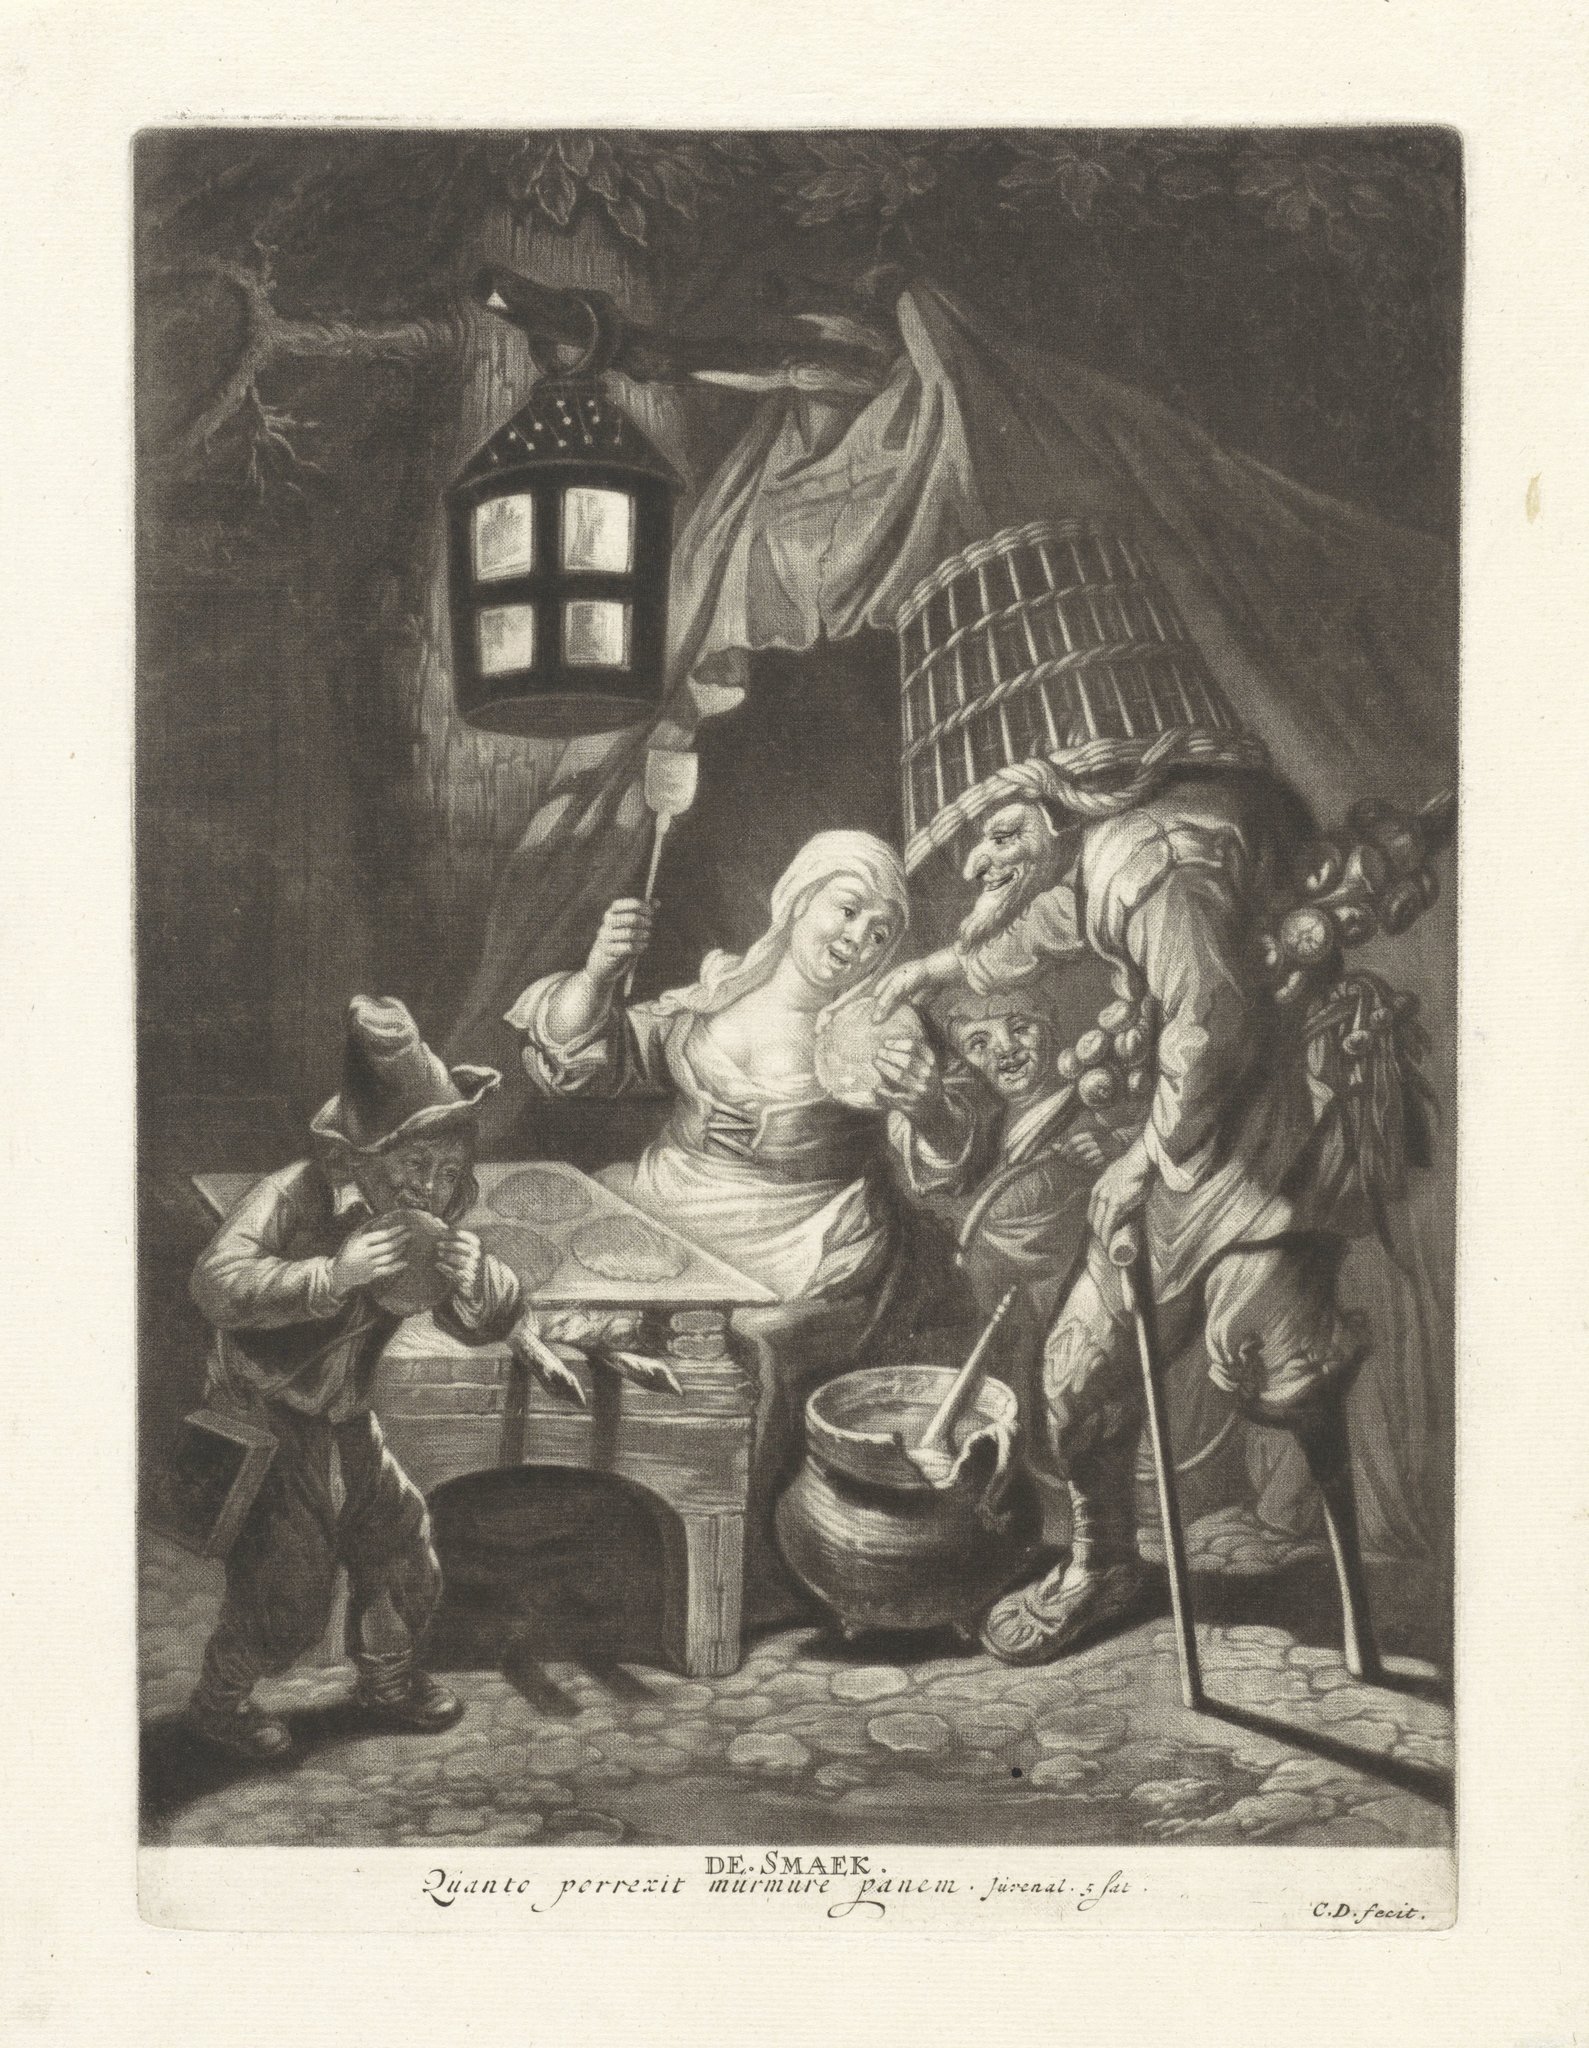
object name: print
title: De smaak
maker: cornelis dusart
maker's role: draughtsman, painter, print maker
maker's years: 1660-1704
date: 1670-1704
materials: paper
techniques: engraving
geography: haarlem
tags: pancakes, taste, tasting (one of the five senses), theft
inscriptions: collector's mark: Lugt 2228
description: Een pannenkoekenbakster zit voor haar tent en probeert een landloper, die een pannenkoek heeft gestolen, op zijn handen te slaan. Op de voorgrond een jongen die een pannenkoek eet. De prent maakt deel uit van een serie van vijf prenten met de vijf zintuigen.